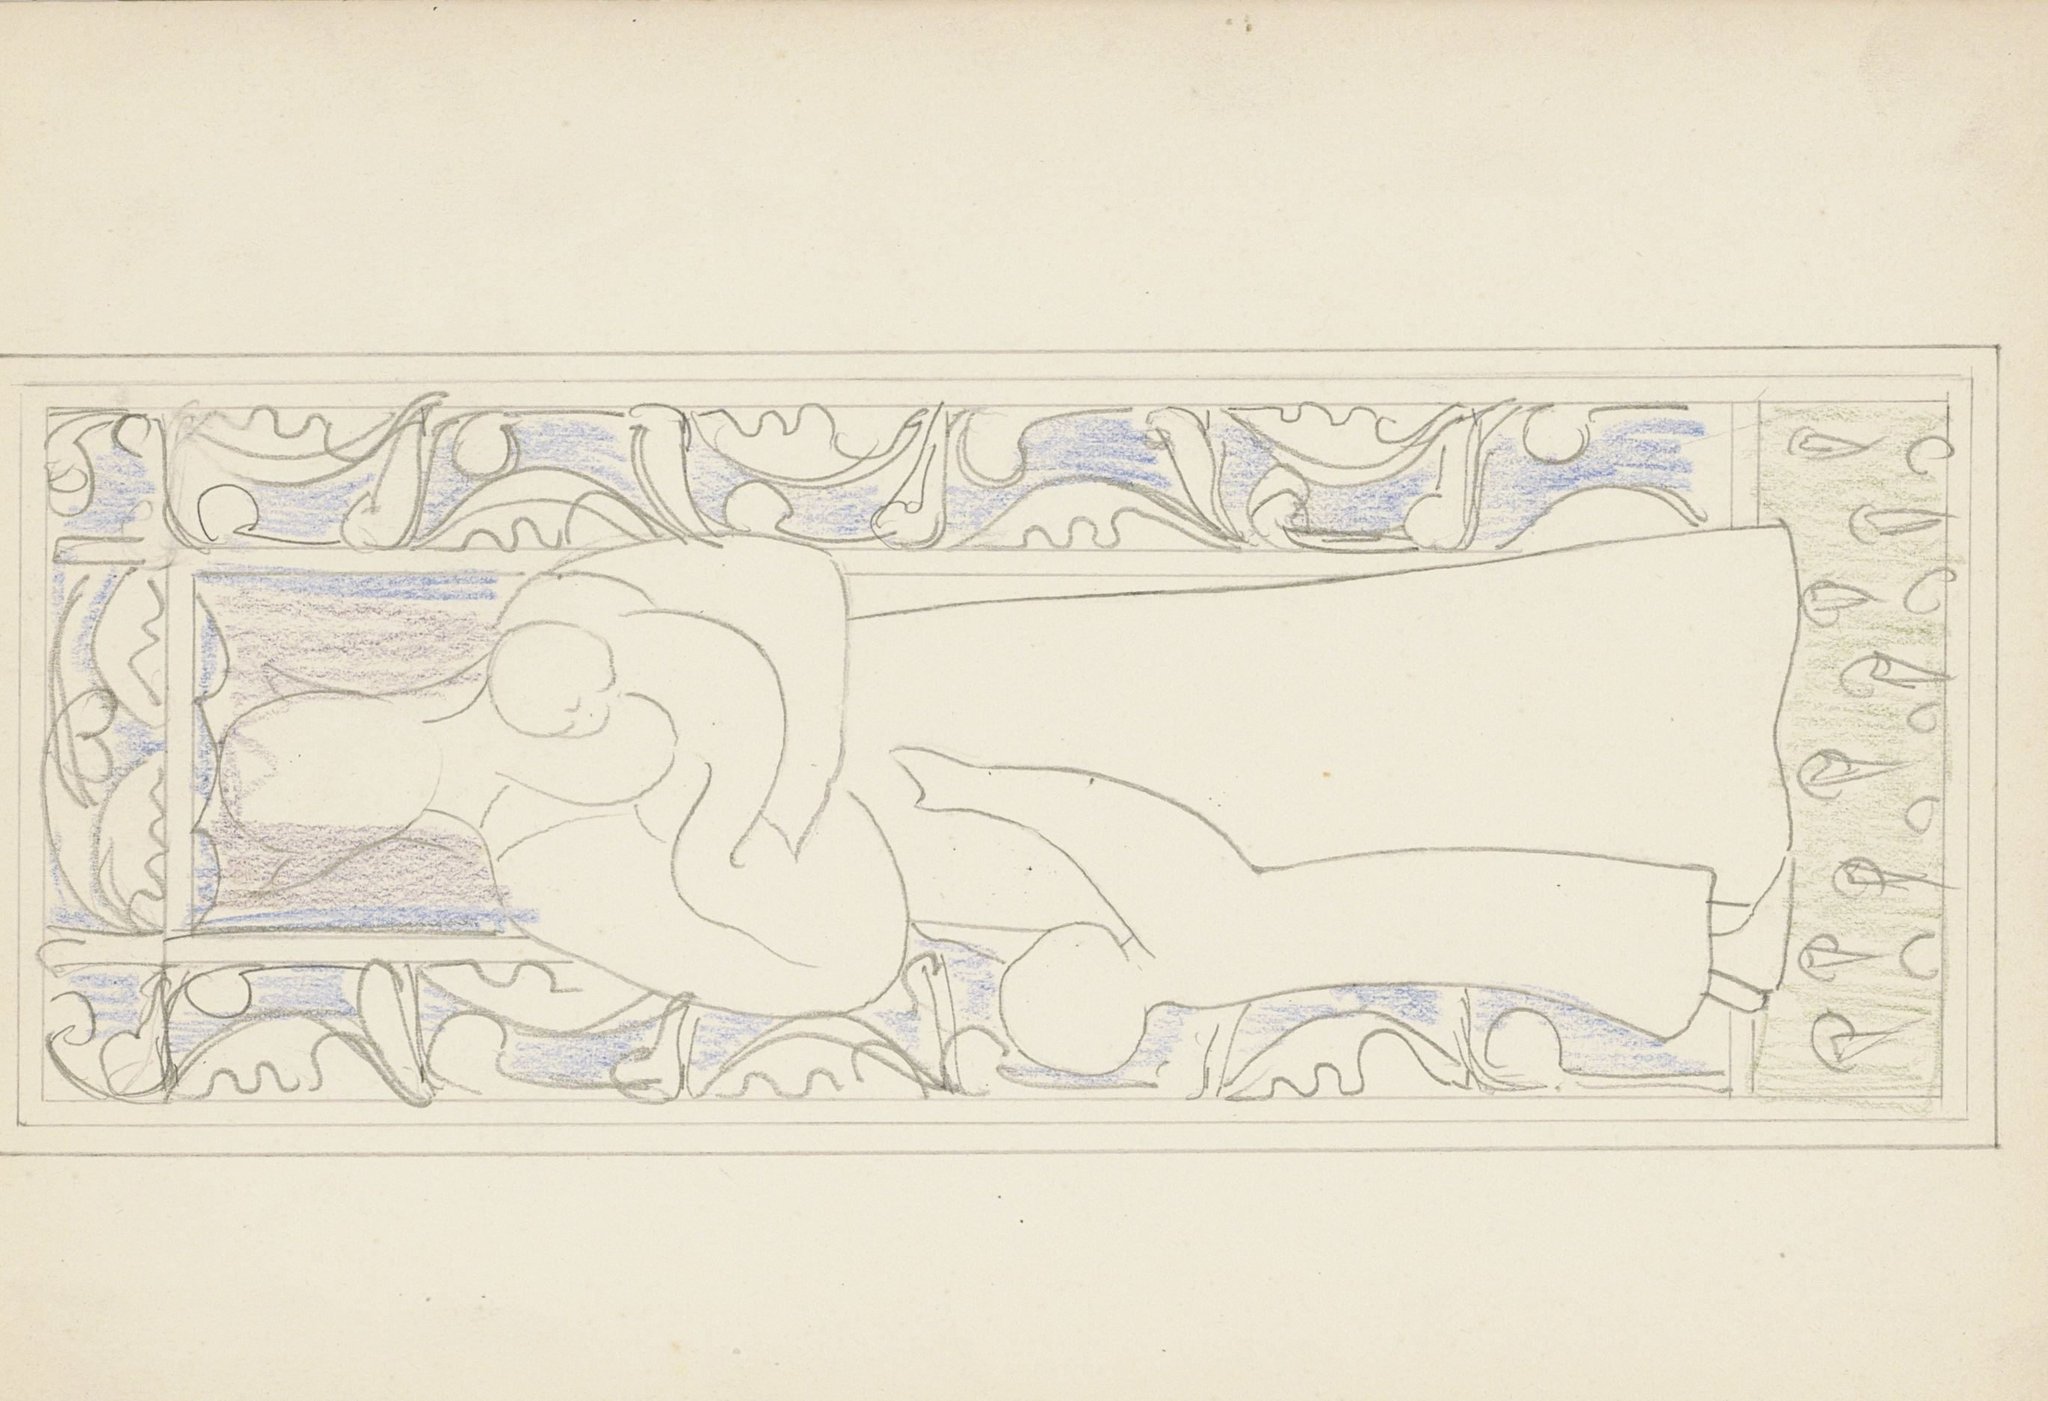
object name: sketchbook leaf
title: Ontwerp voor een venster met een gekroonde vrouw met baby en kind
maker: antoon derkinderen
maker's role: draughtsman, painter, print maker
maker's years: 1859-1925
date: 1900-1903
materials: chalk, paper, pencil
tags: window, mother and child(ren), woman and child(ren) (family group)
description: De figuren staan in een florale omlijsting. Vermoedelijk een personificatie van de moederliefde. Ontwerp voor een glas-in-loodraam voor de Kamer van Koophandel in de Beurs van Berlage te Amsterdam. Blad 22 recto uit een schetsboek met 45 bladen.